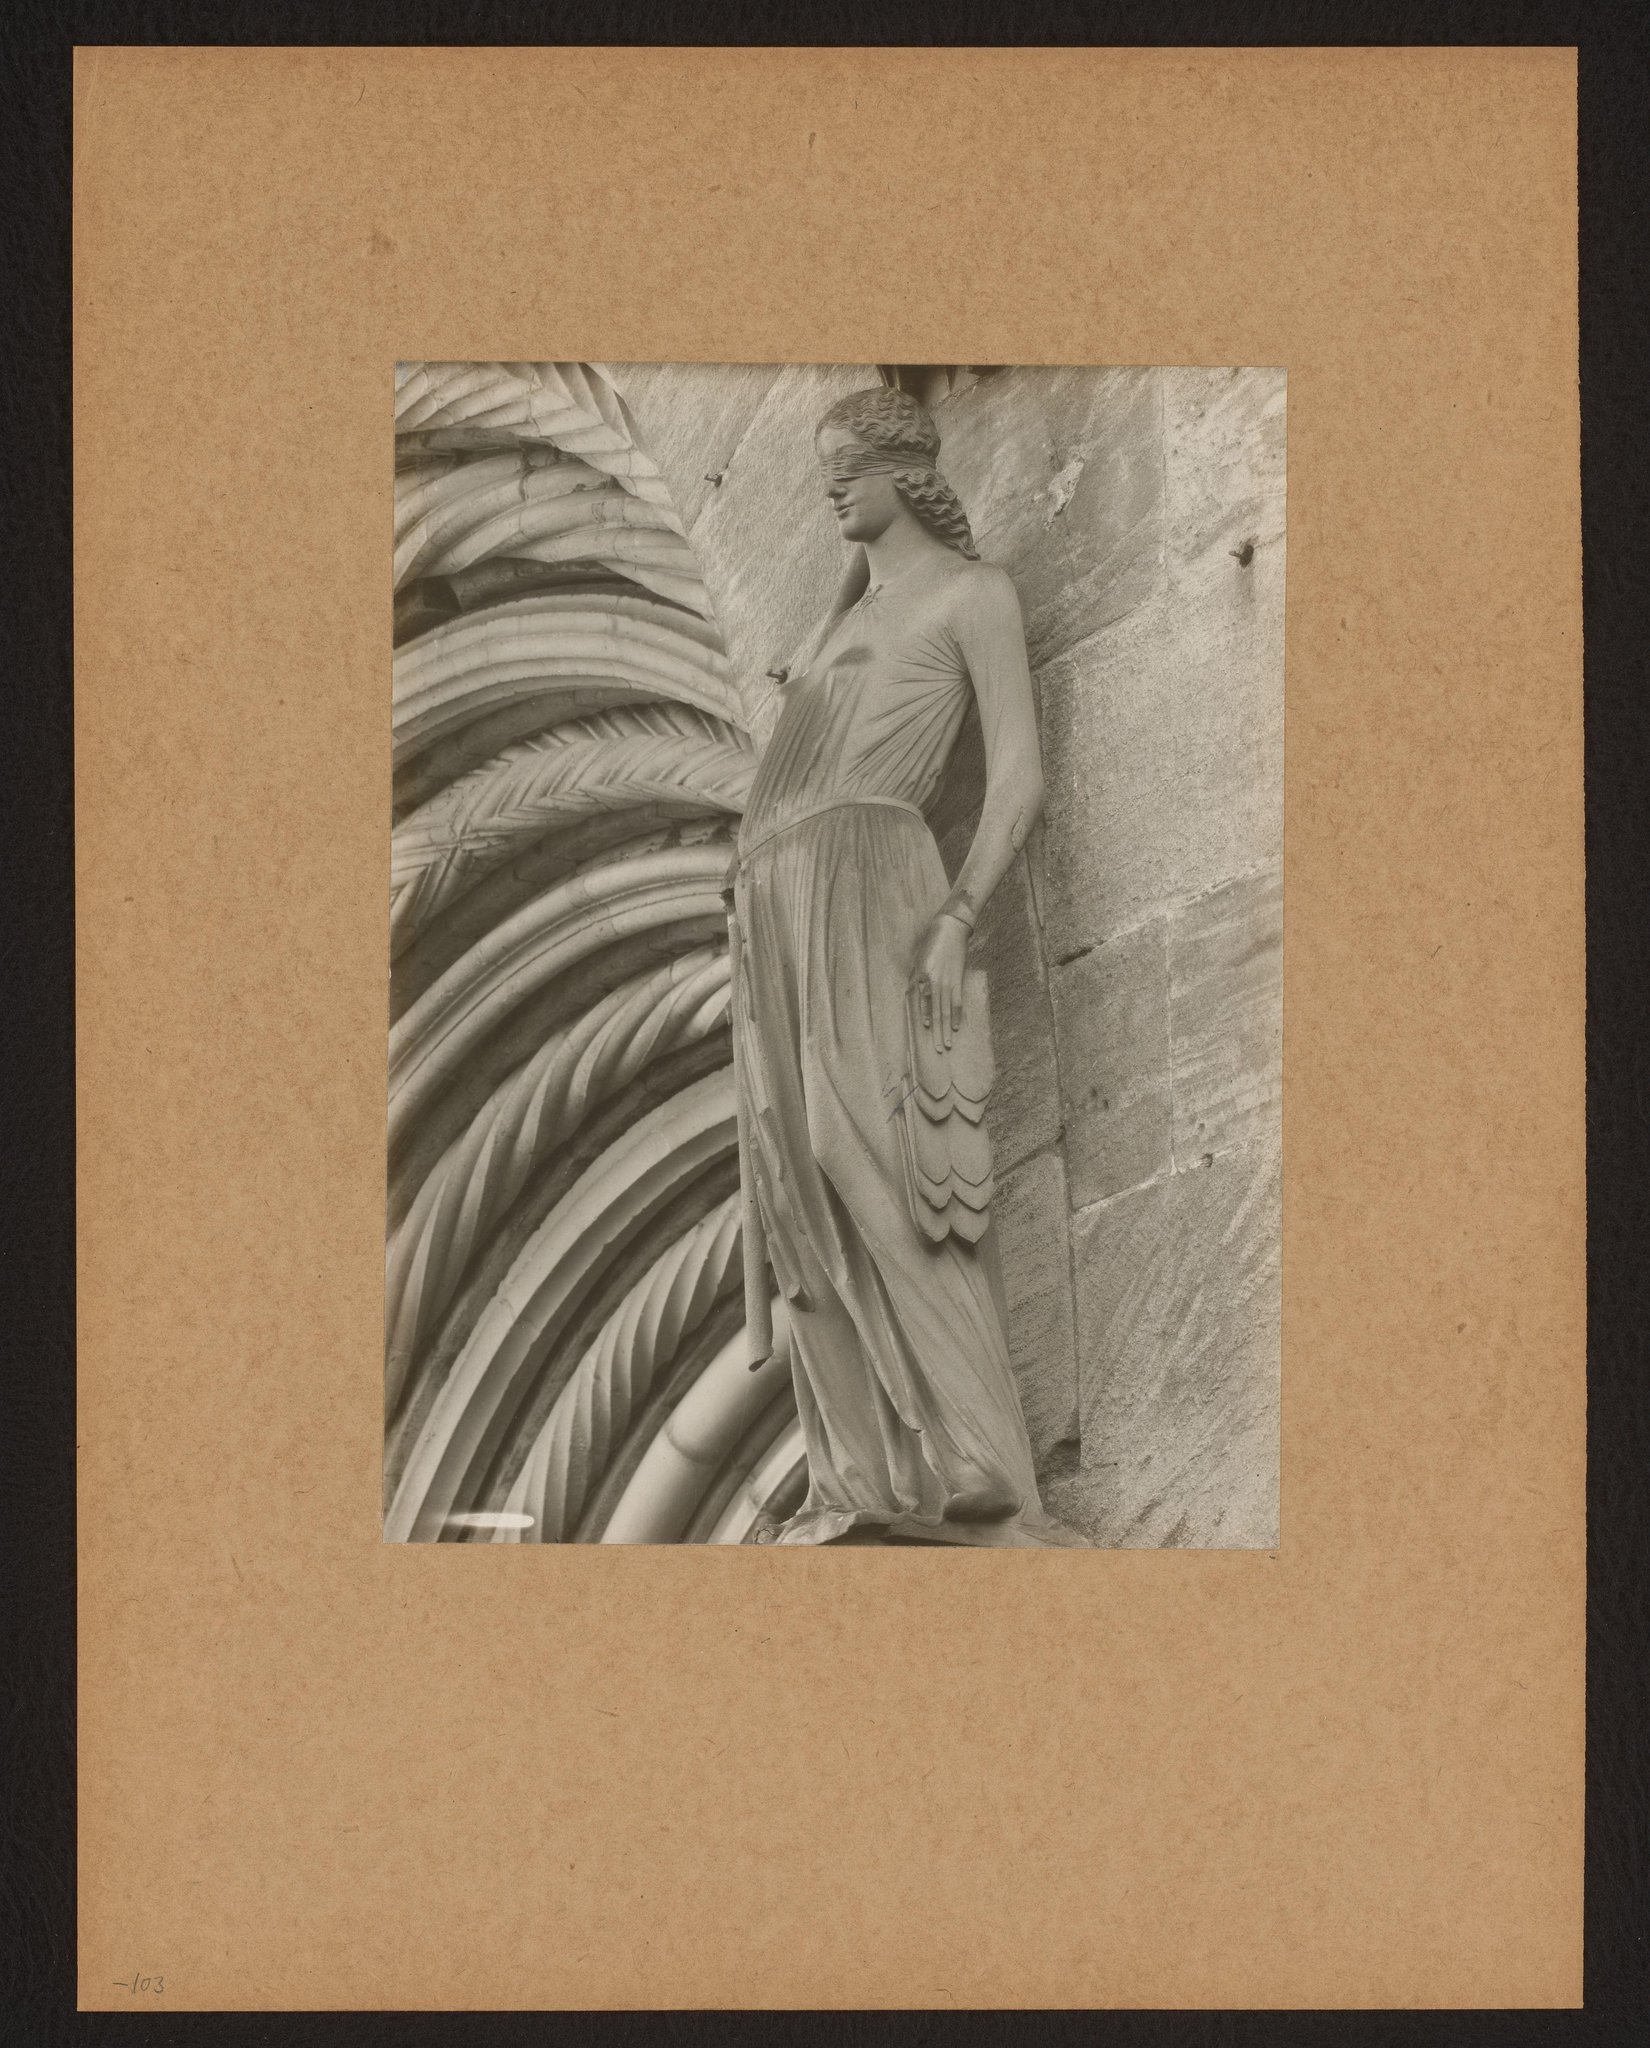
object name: photograph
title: Fürstentor, Synagoge v. halbrechts. 106a, dasselbe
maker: Anonymous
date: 1900-1920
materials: paper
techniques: gelatin silver print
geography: bamberg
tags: church (exterior)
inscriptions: number: ‘106.’